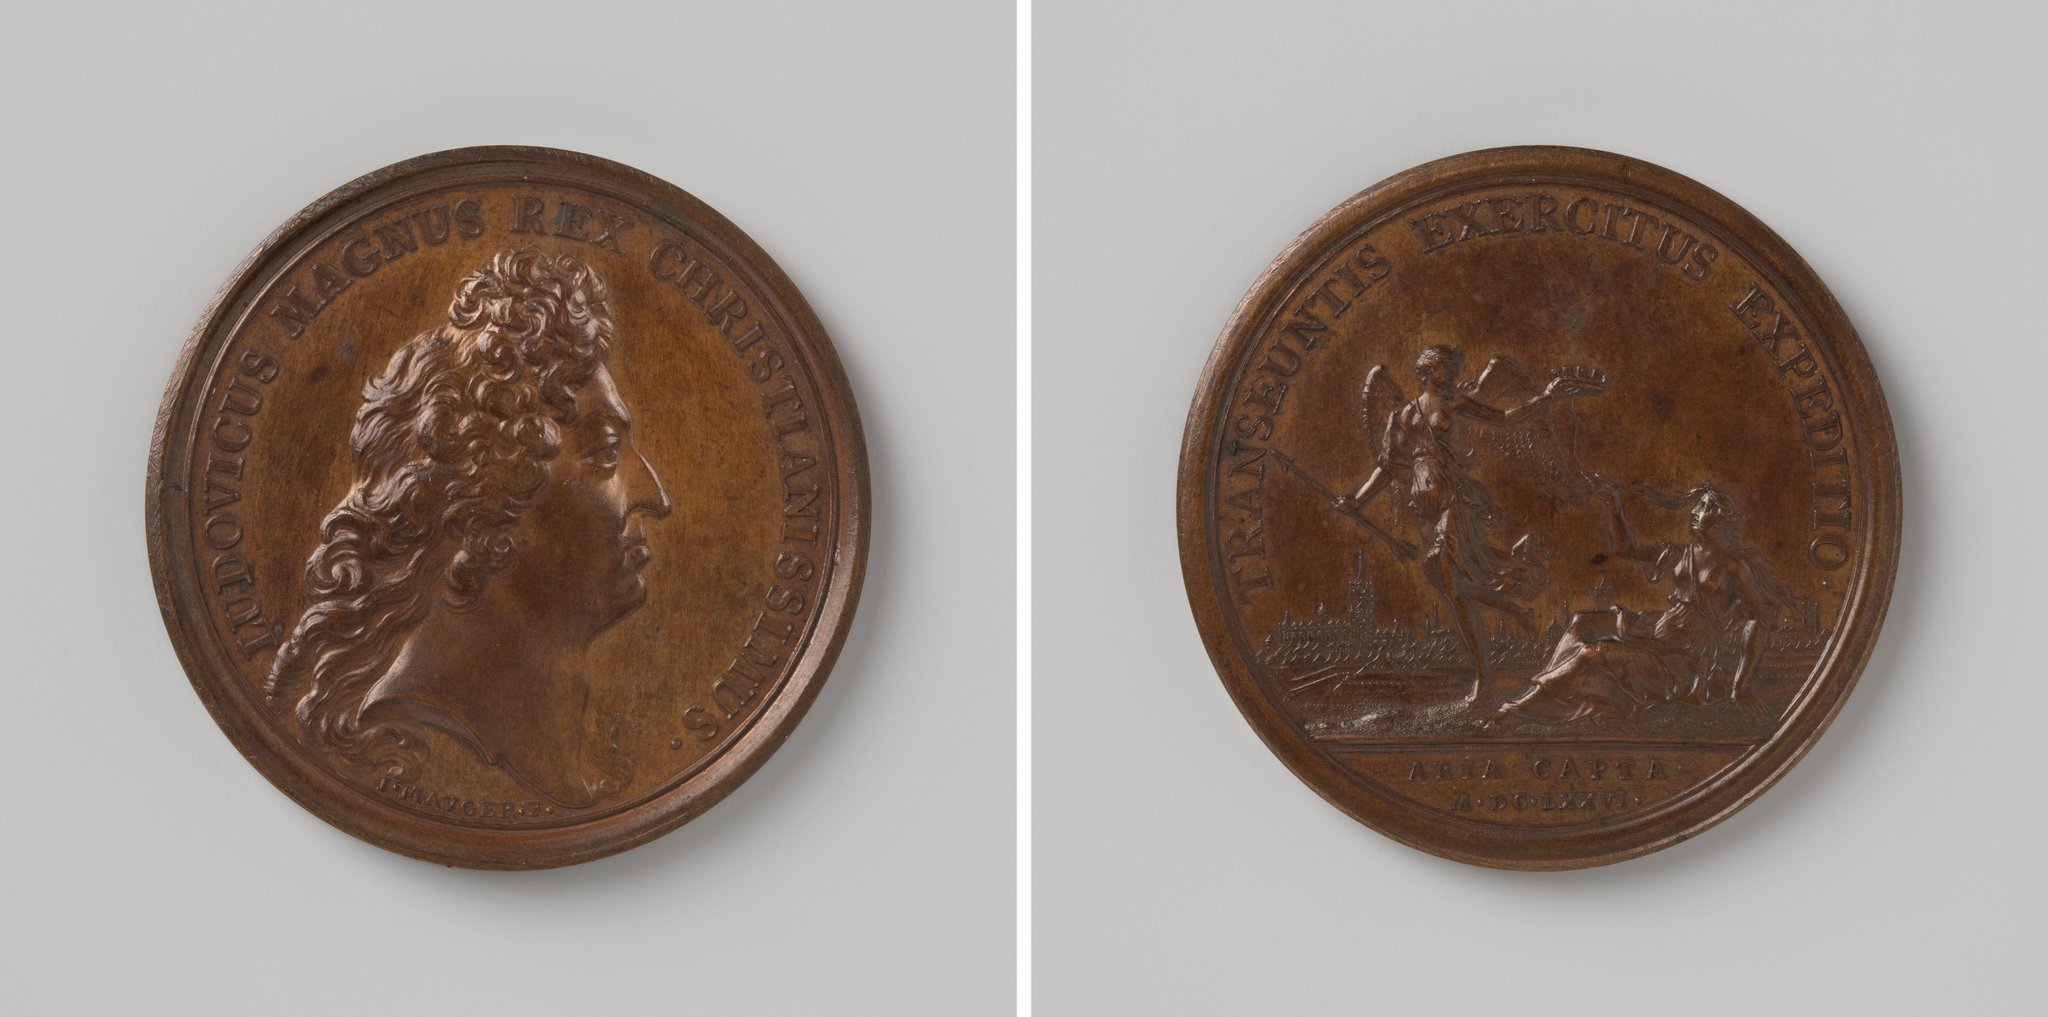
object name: history medal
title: Aire door de Fransen ingenomen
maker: jean mauger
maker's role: medailleur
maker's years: 1648-1722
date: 1676-1699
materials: bronze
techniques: striking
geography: paris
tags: lodewijk xiv (koning van frankrijk)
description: Bronzen penning. Voorzijde: borststuk man binnen omschrift. Keerzijde: de rennende Overwinning grijpt kroon van het hoofd van een zittende vrouw, voorstellende de veroverde stad die op achtergrond zichtbaar is binnen omschrift.